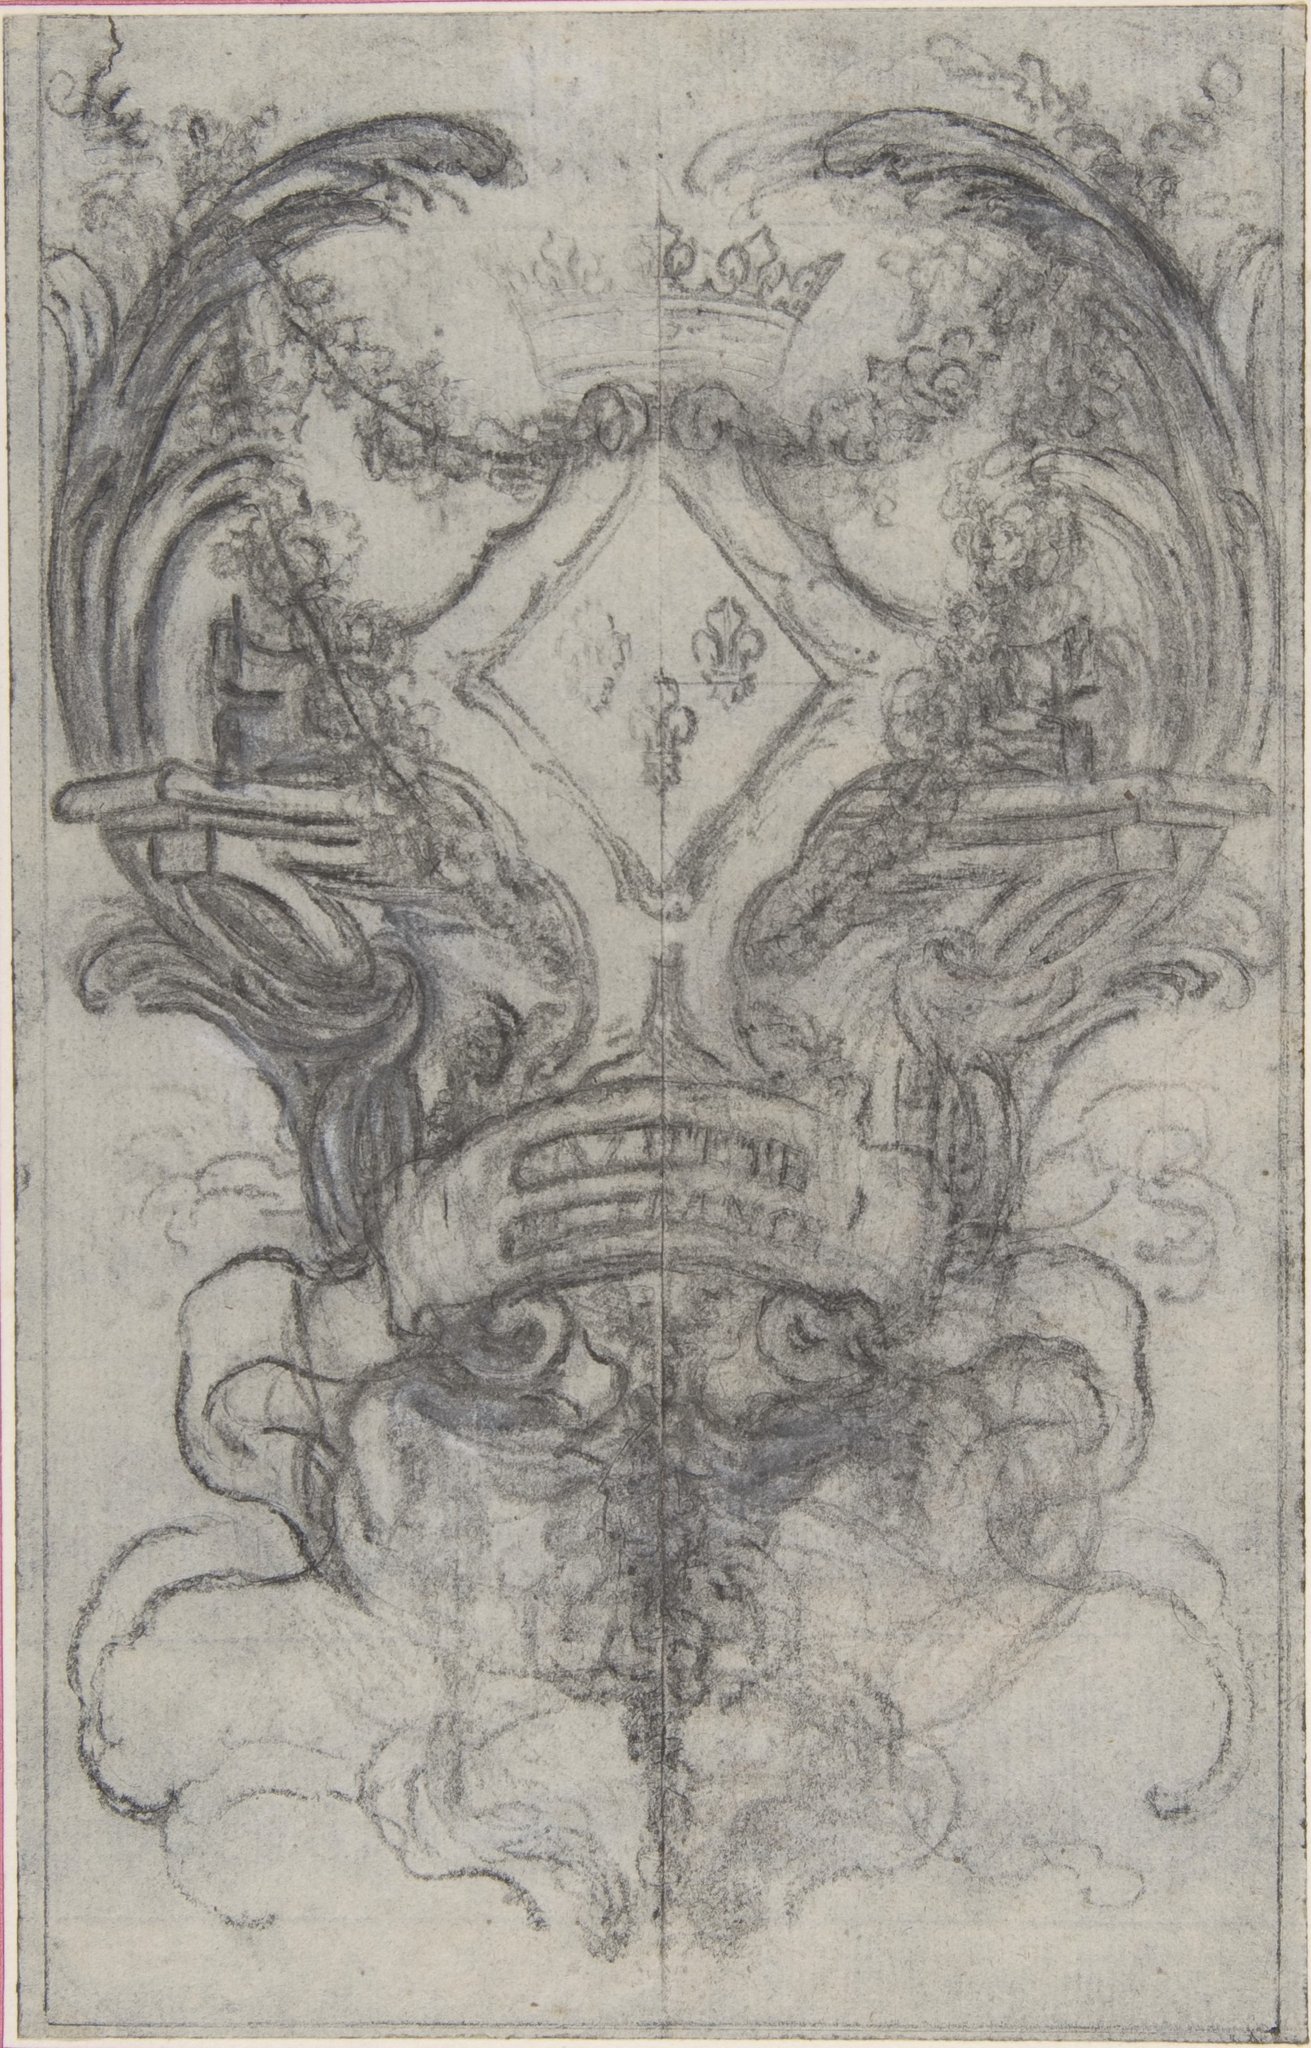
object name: drawing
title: Design for the Headpiece of the "Gazette de France"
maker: hubert françois gravelot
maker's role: artist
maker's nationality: french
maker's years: 1699-1773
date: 1701-1800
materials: chalk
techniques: incising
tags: coat of arms